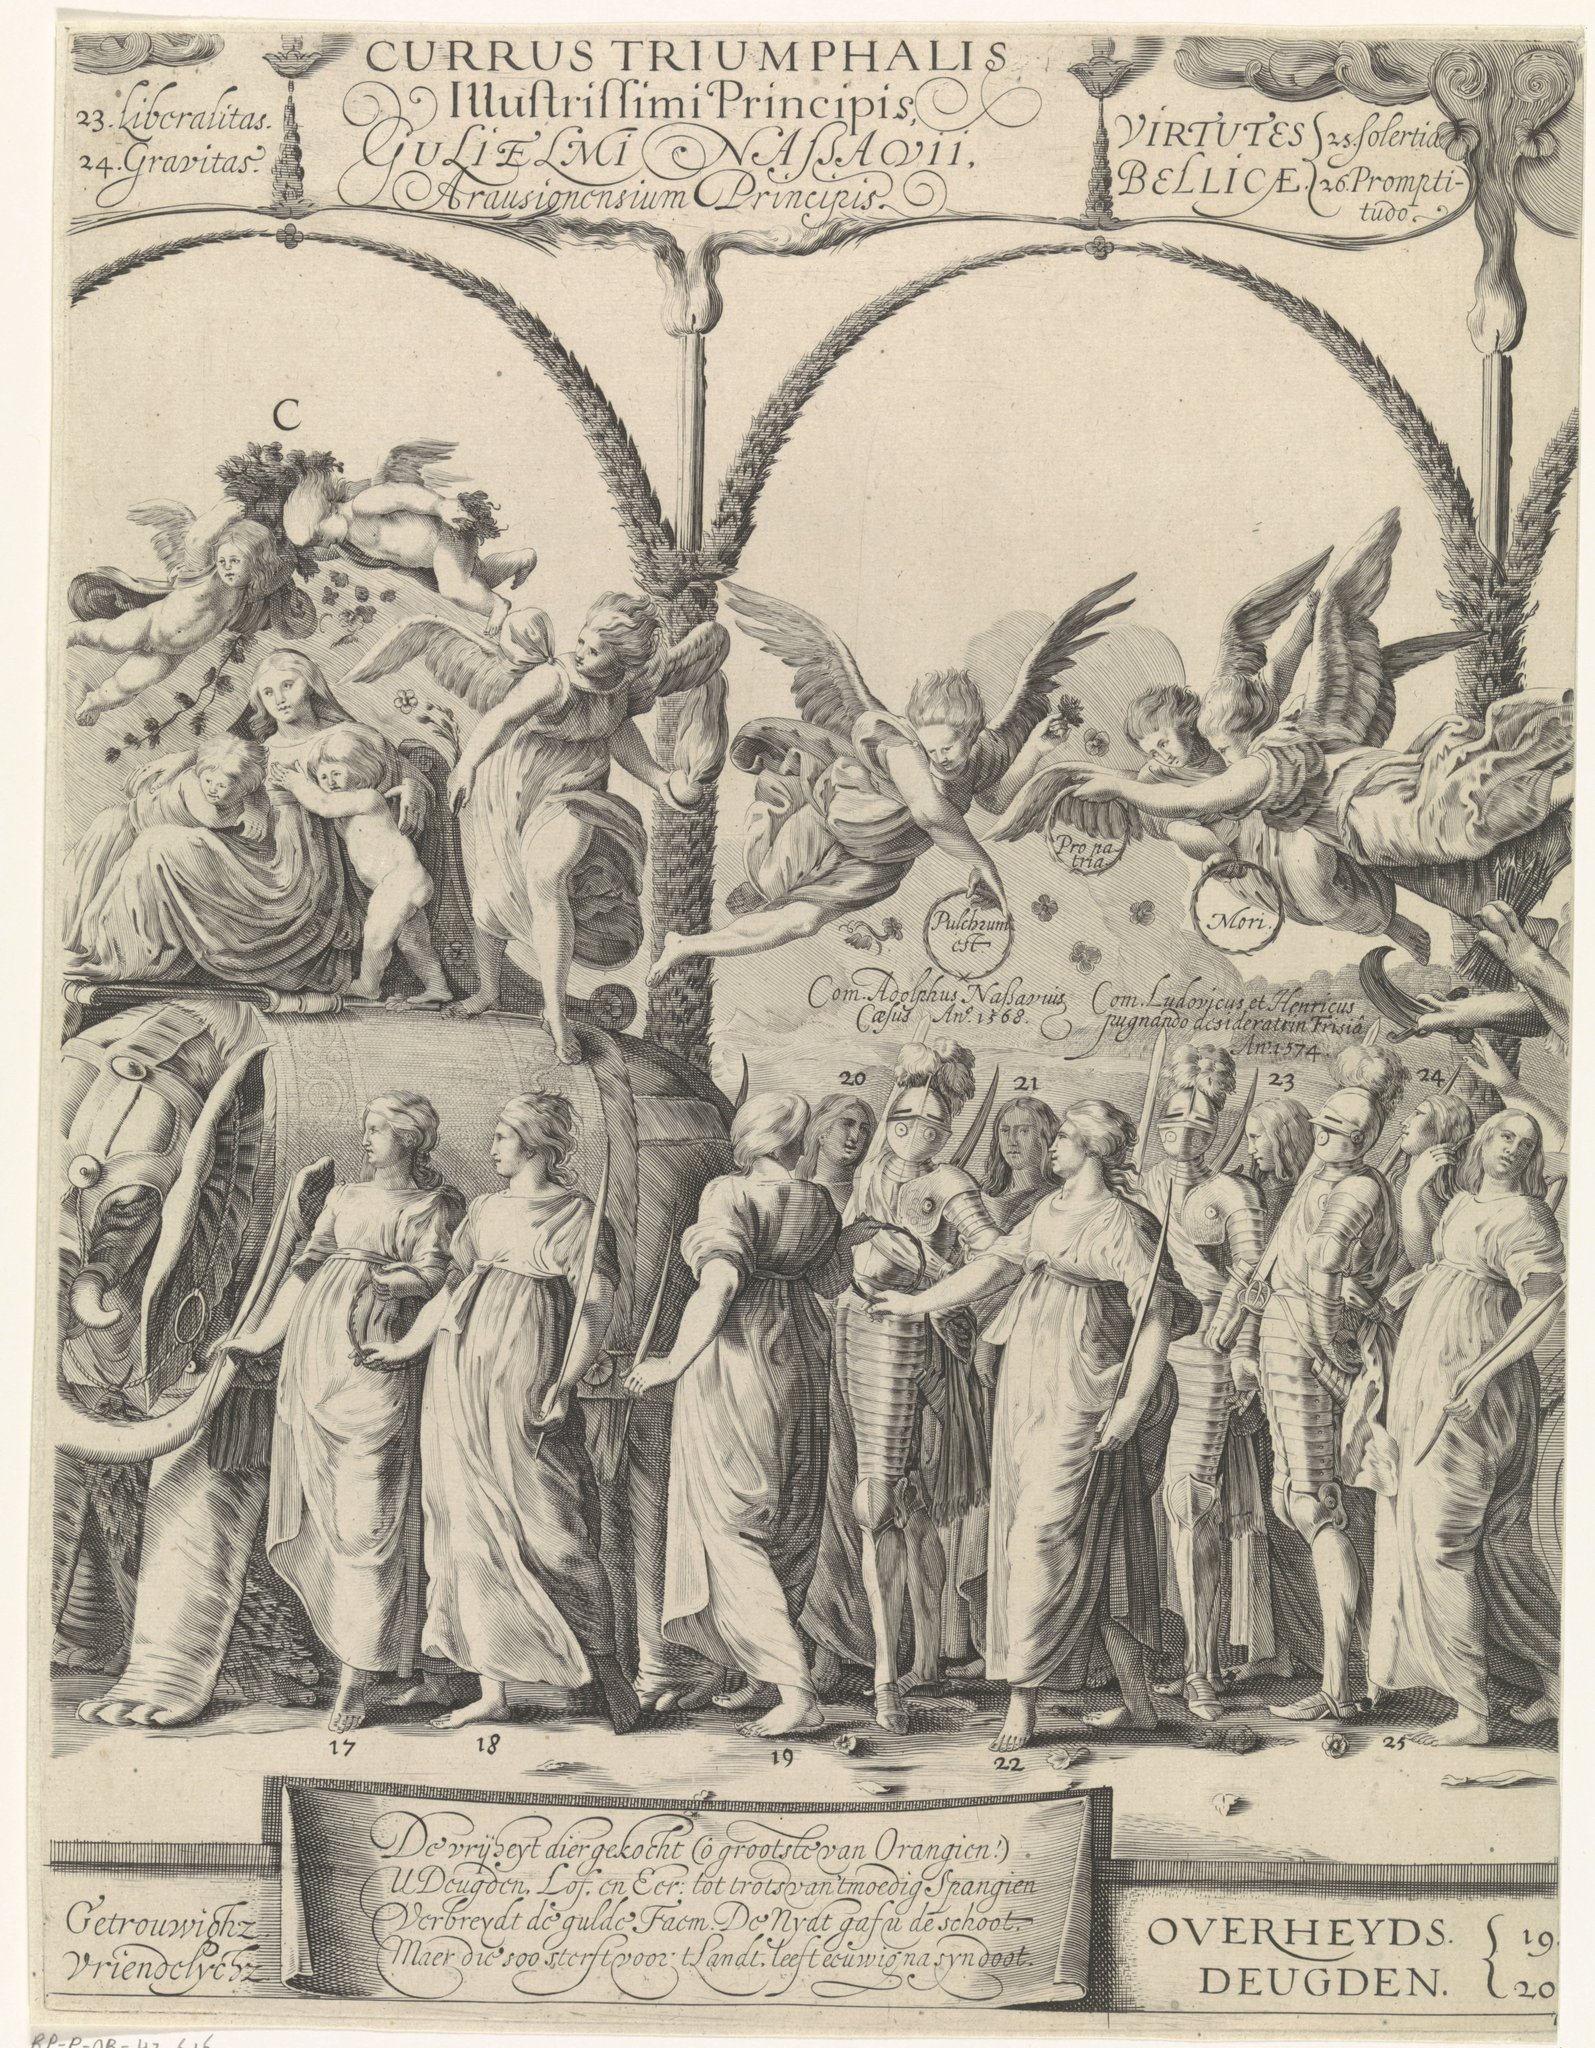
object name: print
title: Triomftocht van Willem van Oranje, middenplaat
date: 1623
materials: paper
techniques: engraving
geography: amsterdam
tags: trunked animals, charity, 'caritas'; 'carità' (ripa) ~ one of the three theological virtues, symbolic triumphs of individual persons, angels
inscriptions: collector's mark: Lugt 2228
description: Middenplaat van vijf platen van 'Triomftocht van Willem van Oranje' met zinnebeeldige voorstellingen van de deugden van Prins Willem van Oranje, bestaande uit: de Christelijke Deugden, de overheidsdeugden en de krijgsdeugden. In deze prent staan de Christelijke Deugden en de Overheids Deugden centraal. Links (onder de C) een olifant met op zijn rug de personificatie van Naastenliefde met twee kinderen bij haar, een van de Christelijke Deugden. Om de olifant heen vliegen putti en lopen andere personificaties van deugden die met het geloof verbonden zijn, zoals Zachtmoedigheid (15) en Barmhartigheid (16). Daarnaast lopen soldaten en personificaties van de Deugden rond zoals Wijsheid (20), Rechtvaardigheid (21) en Mildheid (23). Boven deze deugden vliegen drie engelen die bloemen strooien en lauwerkransen vasthouden. Boven in het midden de titel van de prent en onder de afbeelding een vierregelig Nederlandstalig vers. De personificaties zijn voorzien van een nummer, waarvan de verklaring in het Latijn boven de afbeelding en in het Nederlands onder de afbeelding staat.